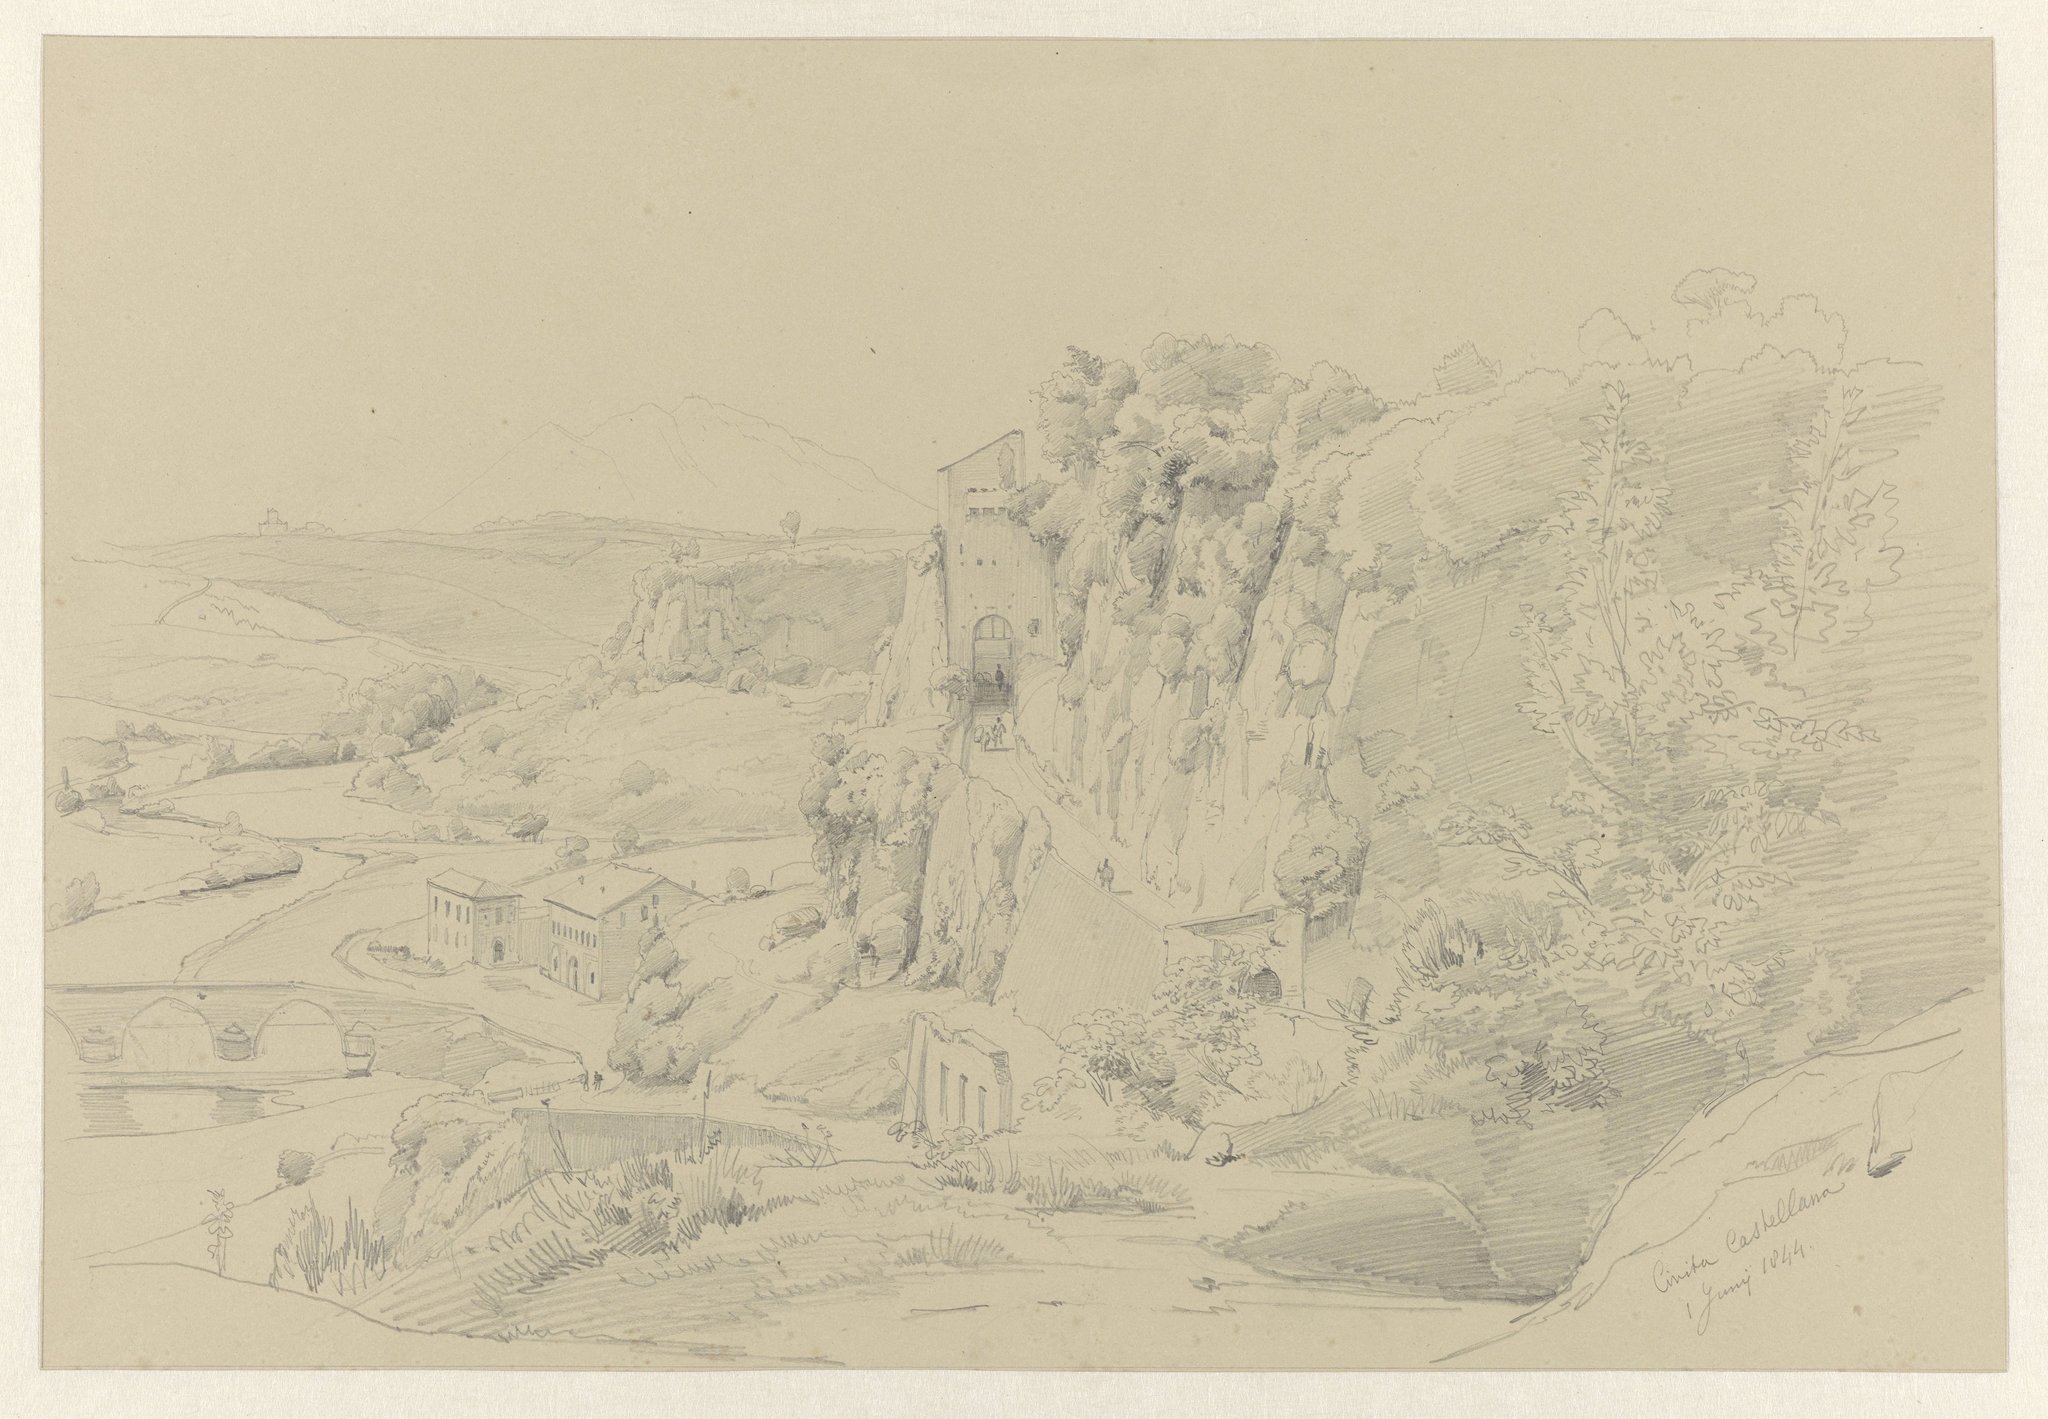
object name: drawing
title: Civita Castellana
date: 1844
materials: chalk, paper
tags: rocks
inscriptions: date and inscription: ‘Civita Castellana / 1 Juny 1844’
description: Tekening uit een groep tekeningen van landschappen en stadsgezichten in Italië (Rome, Tivoli, Civita Castellana en Pozzuoli).